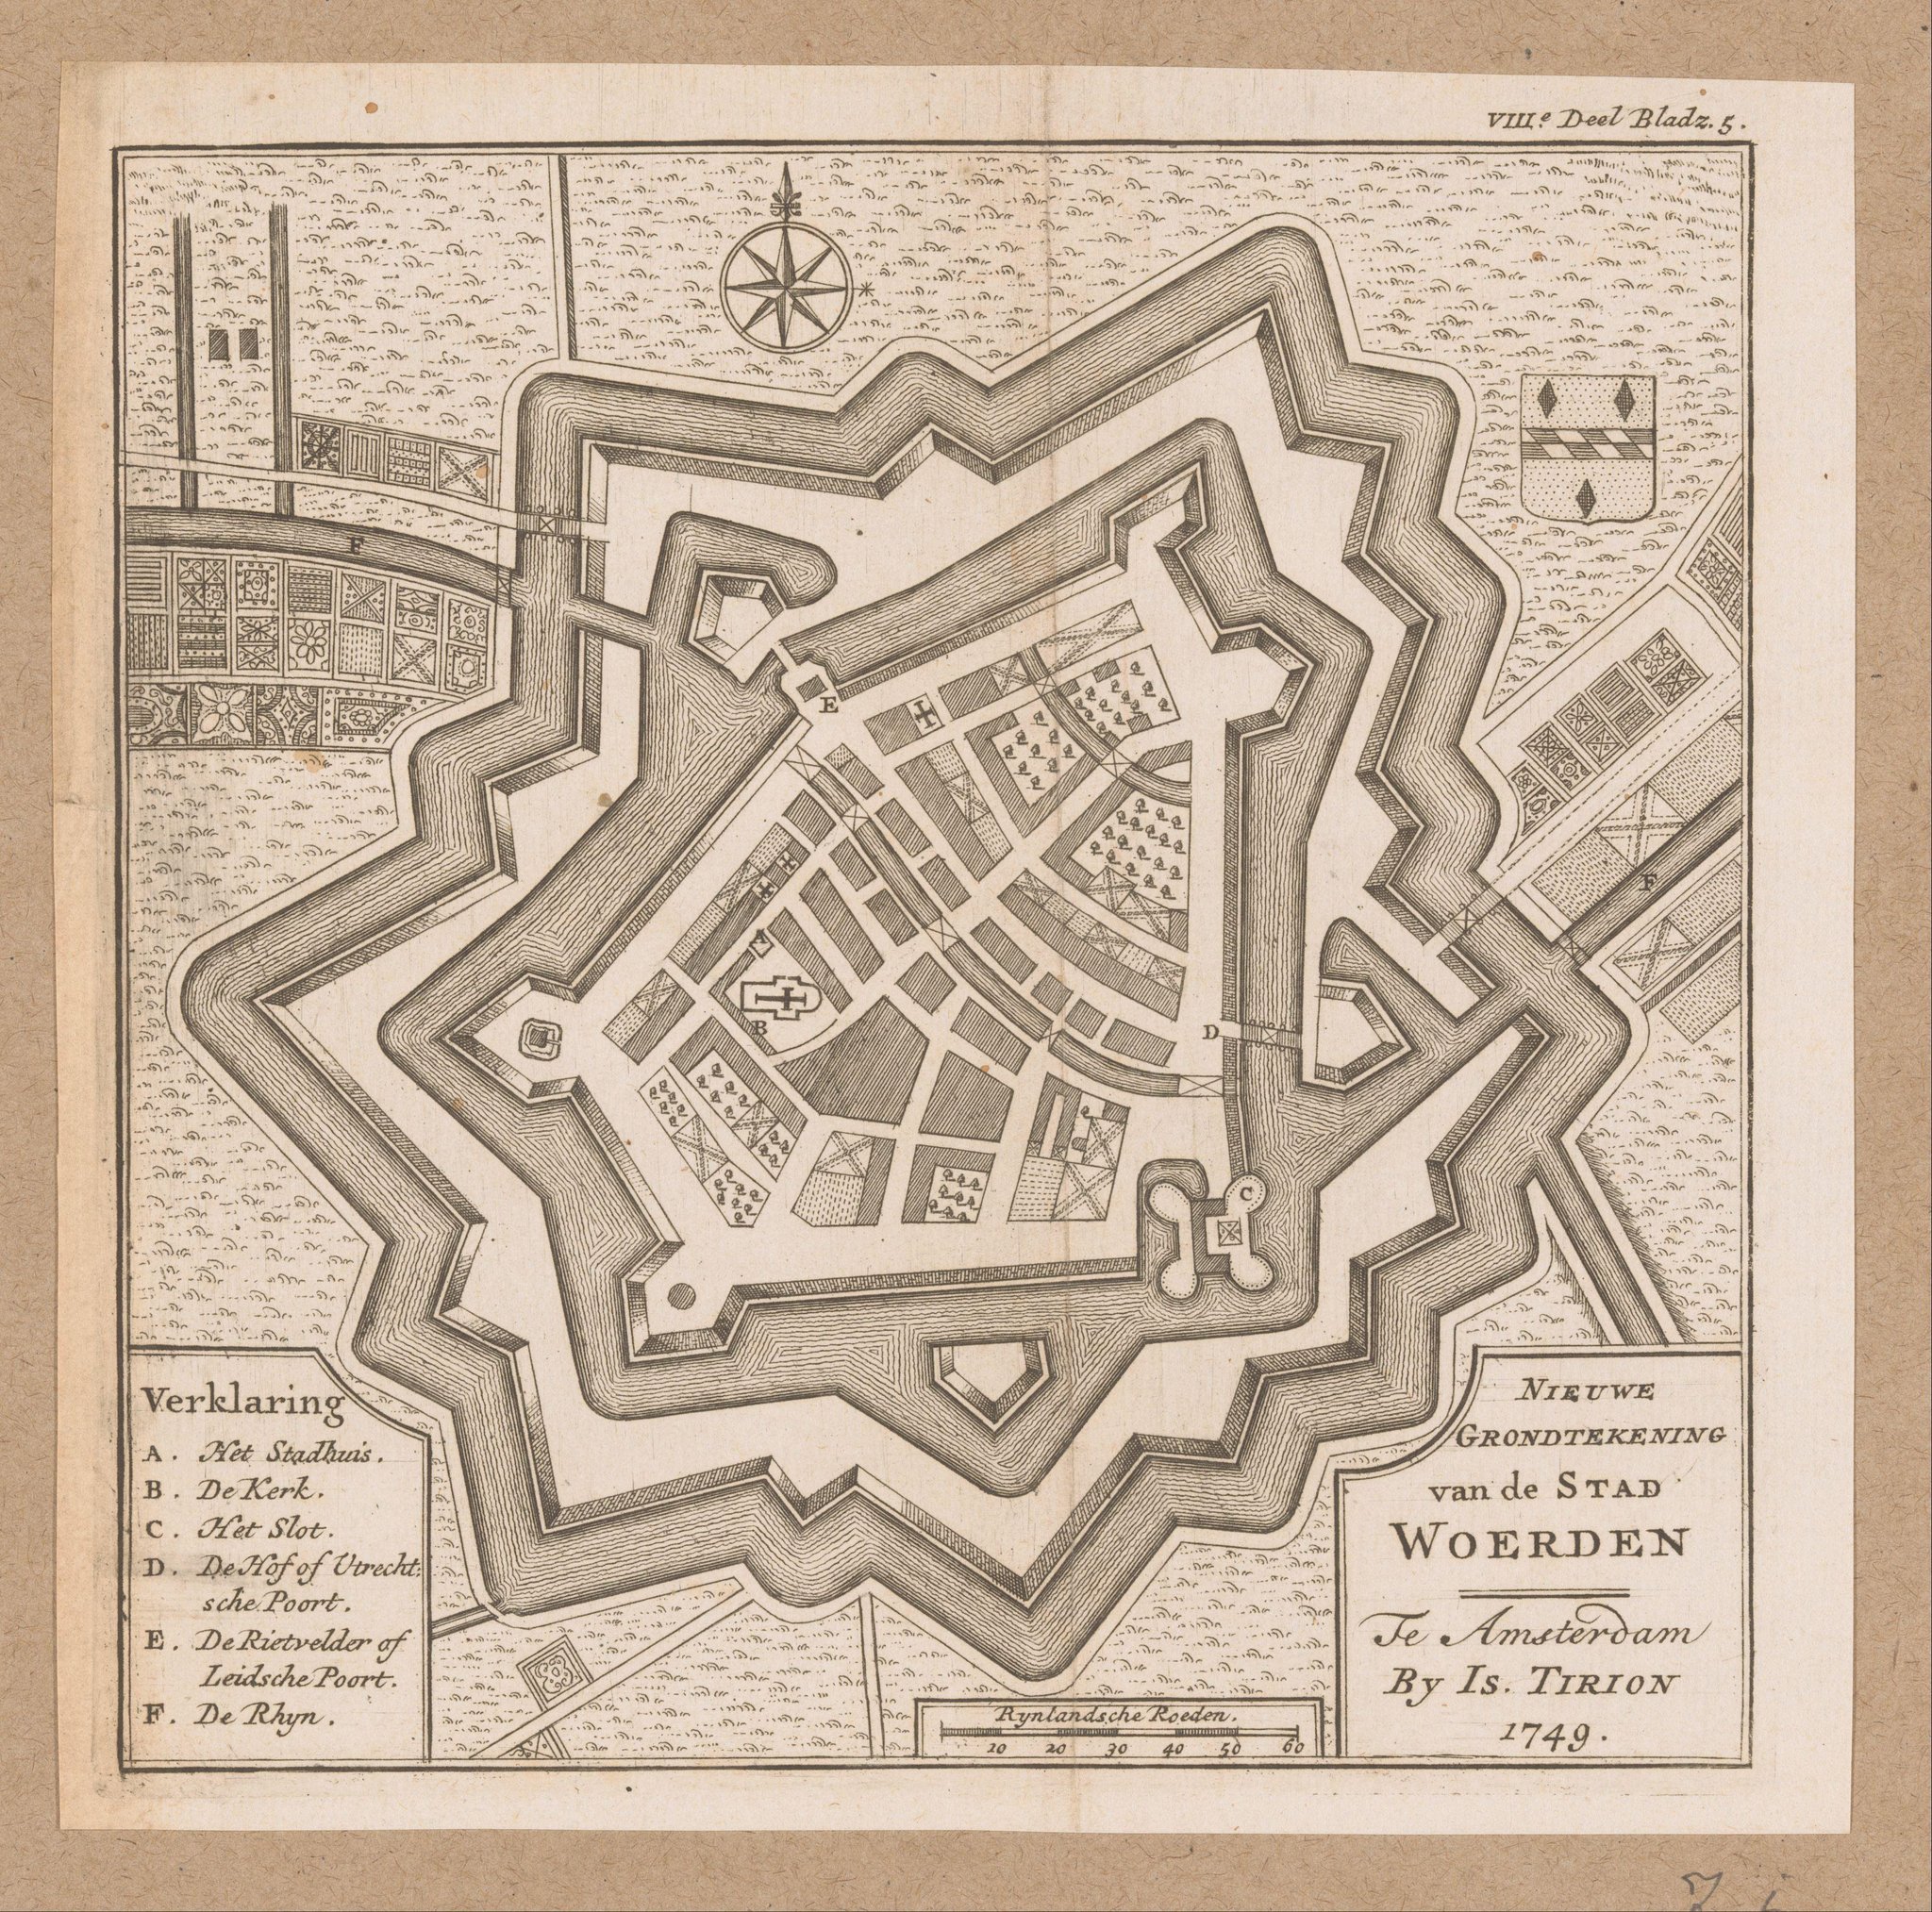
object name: print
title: Nieuwe Grondtekening van de Stad Woerden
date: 1749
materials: paper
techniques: etching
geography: amsterdam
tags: maps of cities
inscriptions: date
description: Prent ook verschenen in: Beknopte Atlas van omtrent Honderd Platte Gronden (...) van Europa. Amsterdam: Compagnie van boekverkopers, [na 1780].